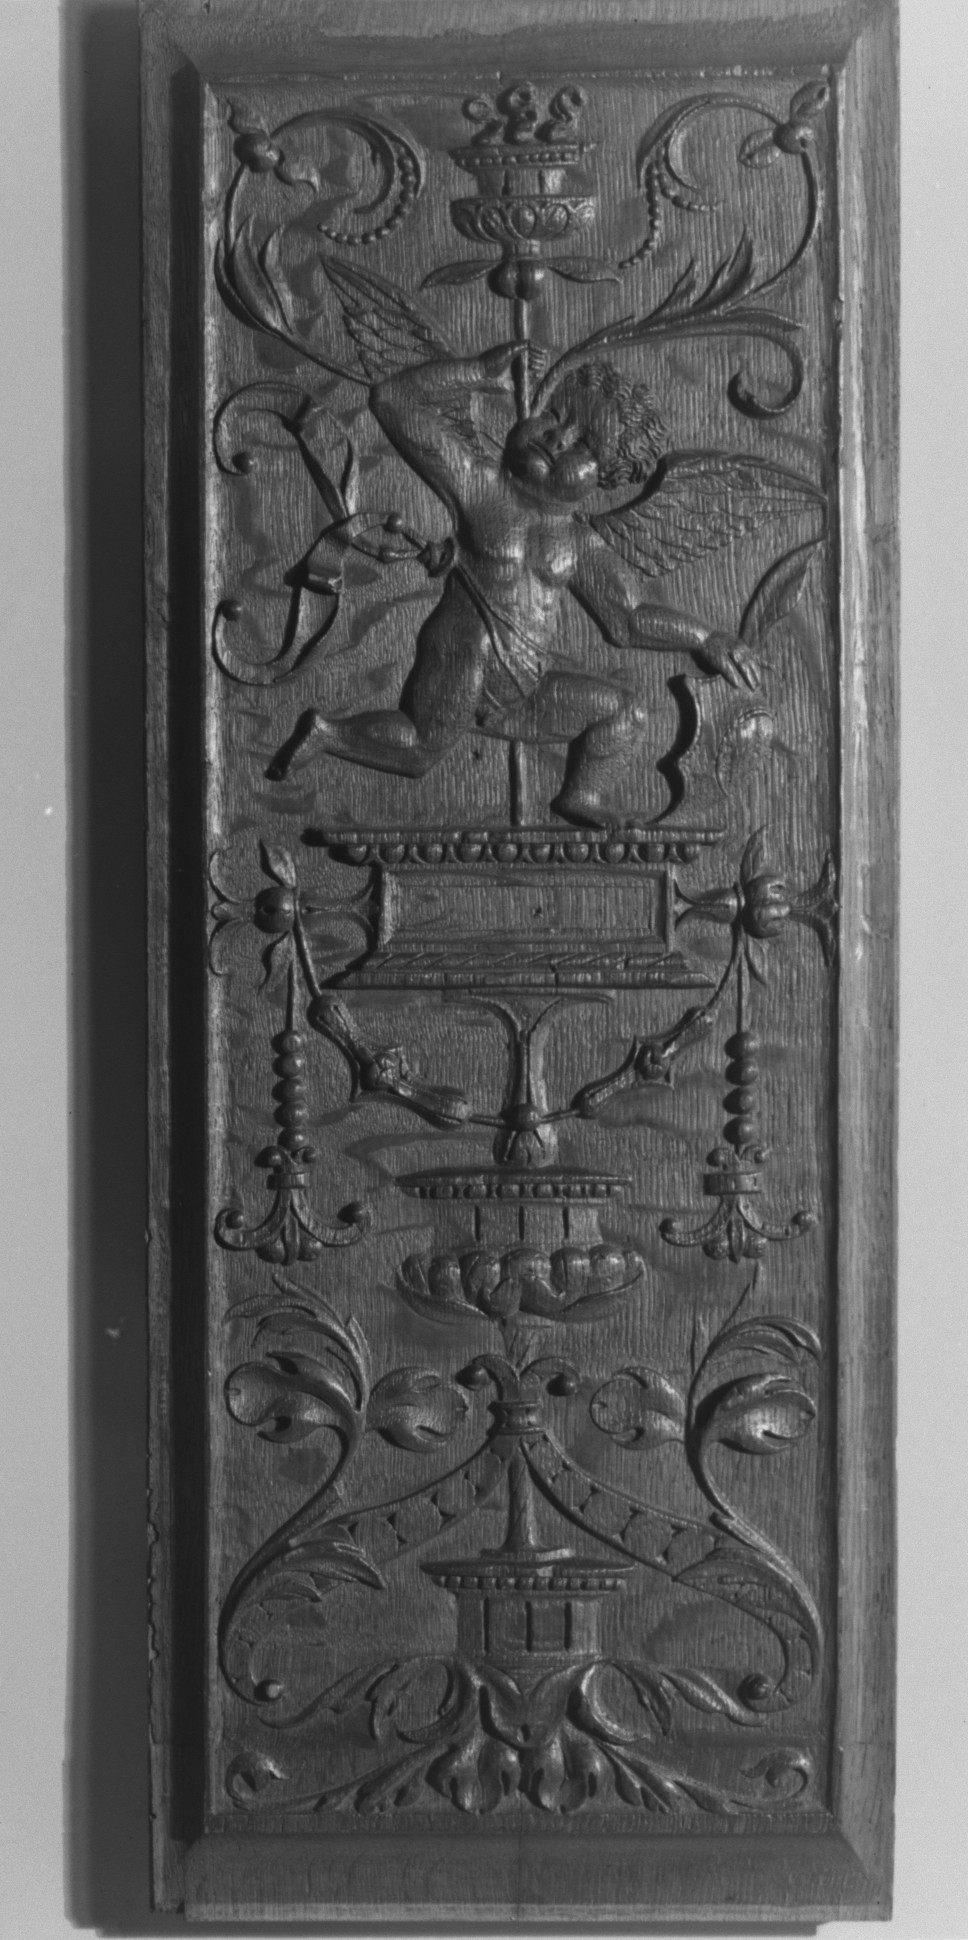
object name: panel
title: Panel (part of a set)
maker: nicolas castille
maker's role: maker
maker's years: 1503-1521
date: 1510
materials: wood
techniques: carving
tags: putti